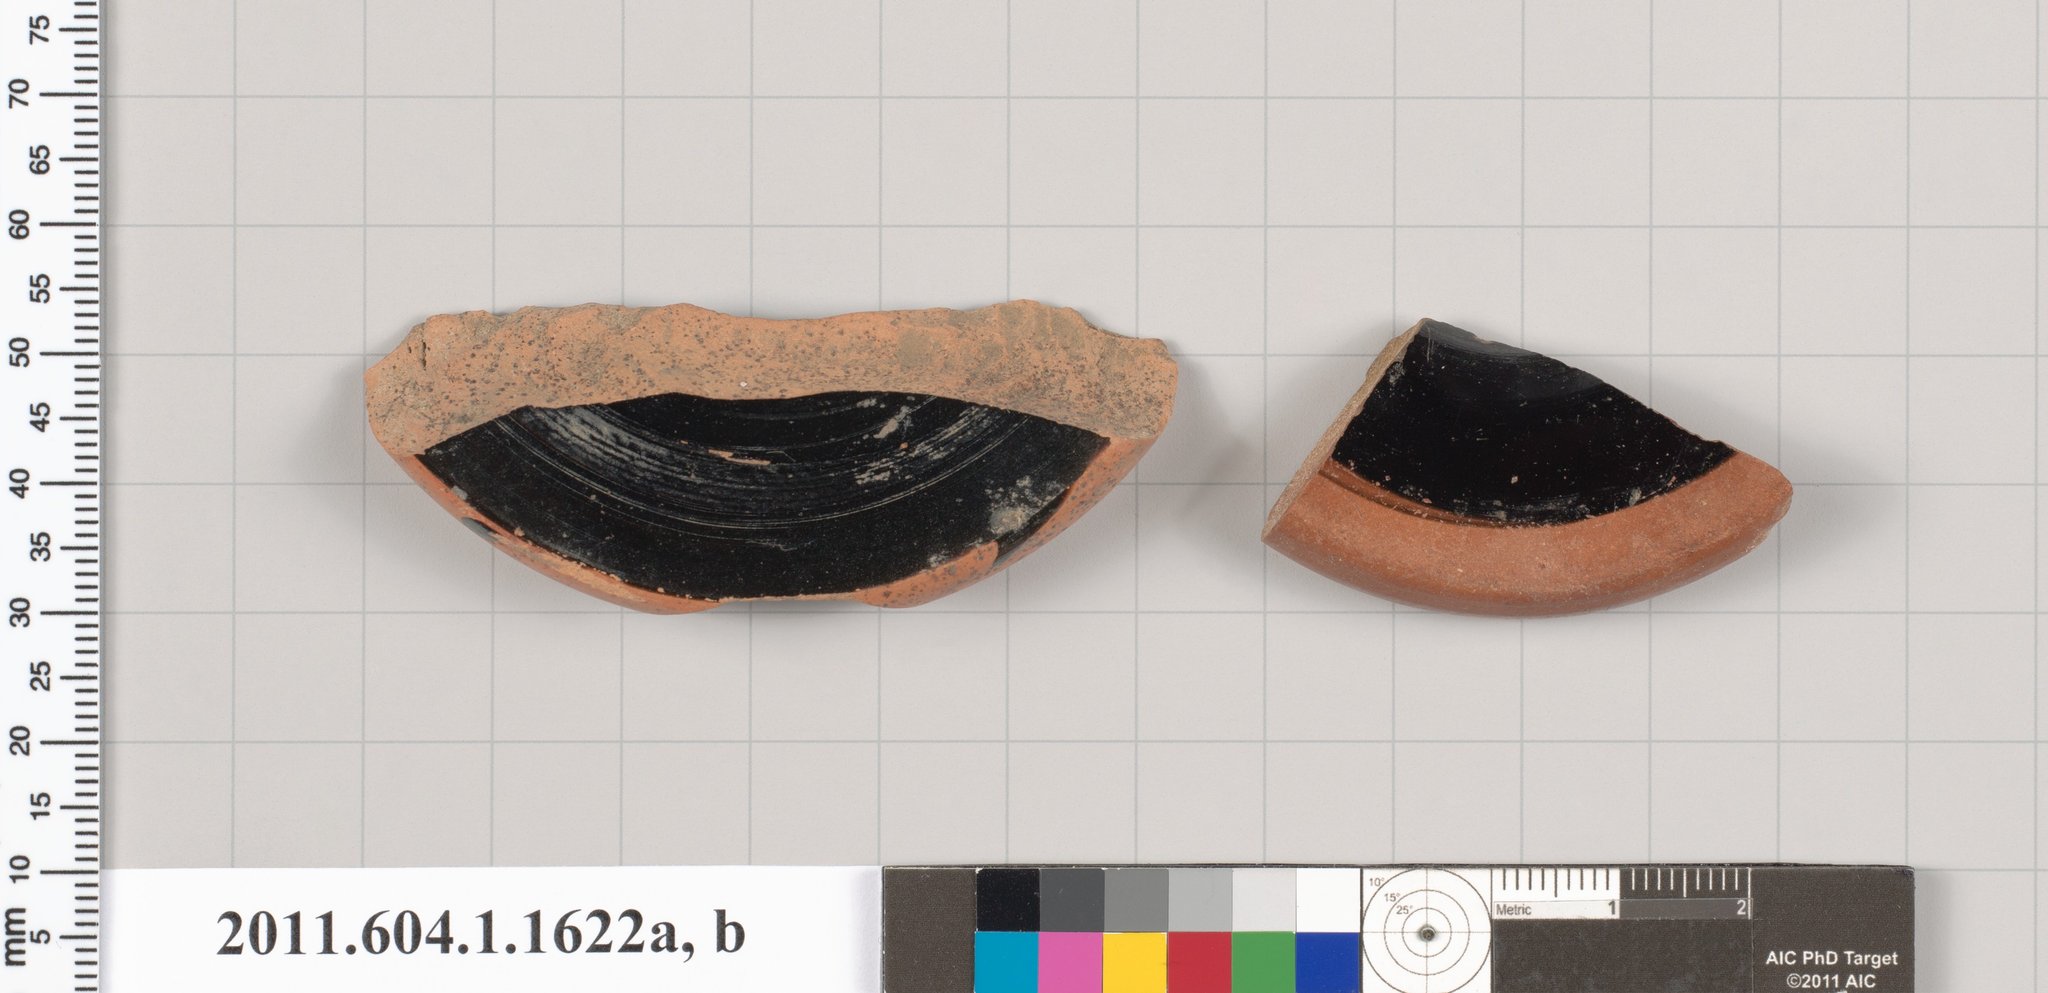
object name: kylix fragment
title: Terracotta fragments of kylikes (drinking cups)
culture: greek, attic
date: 500-401 BCE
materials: terracotta